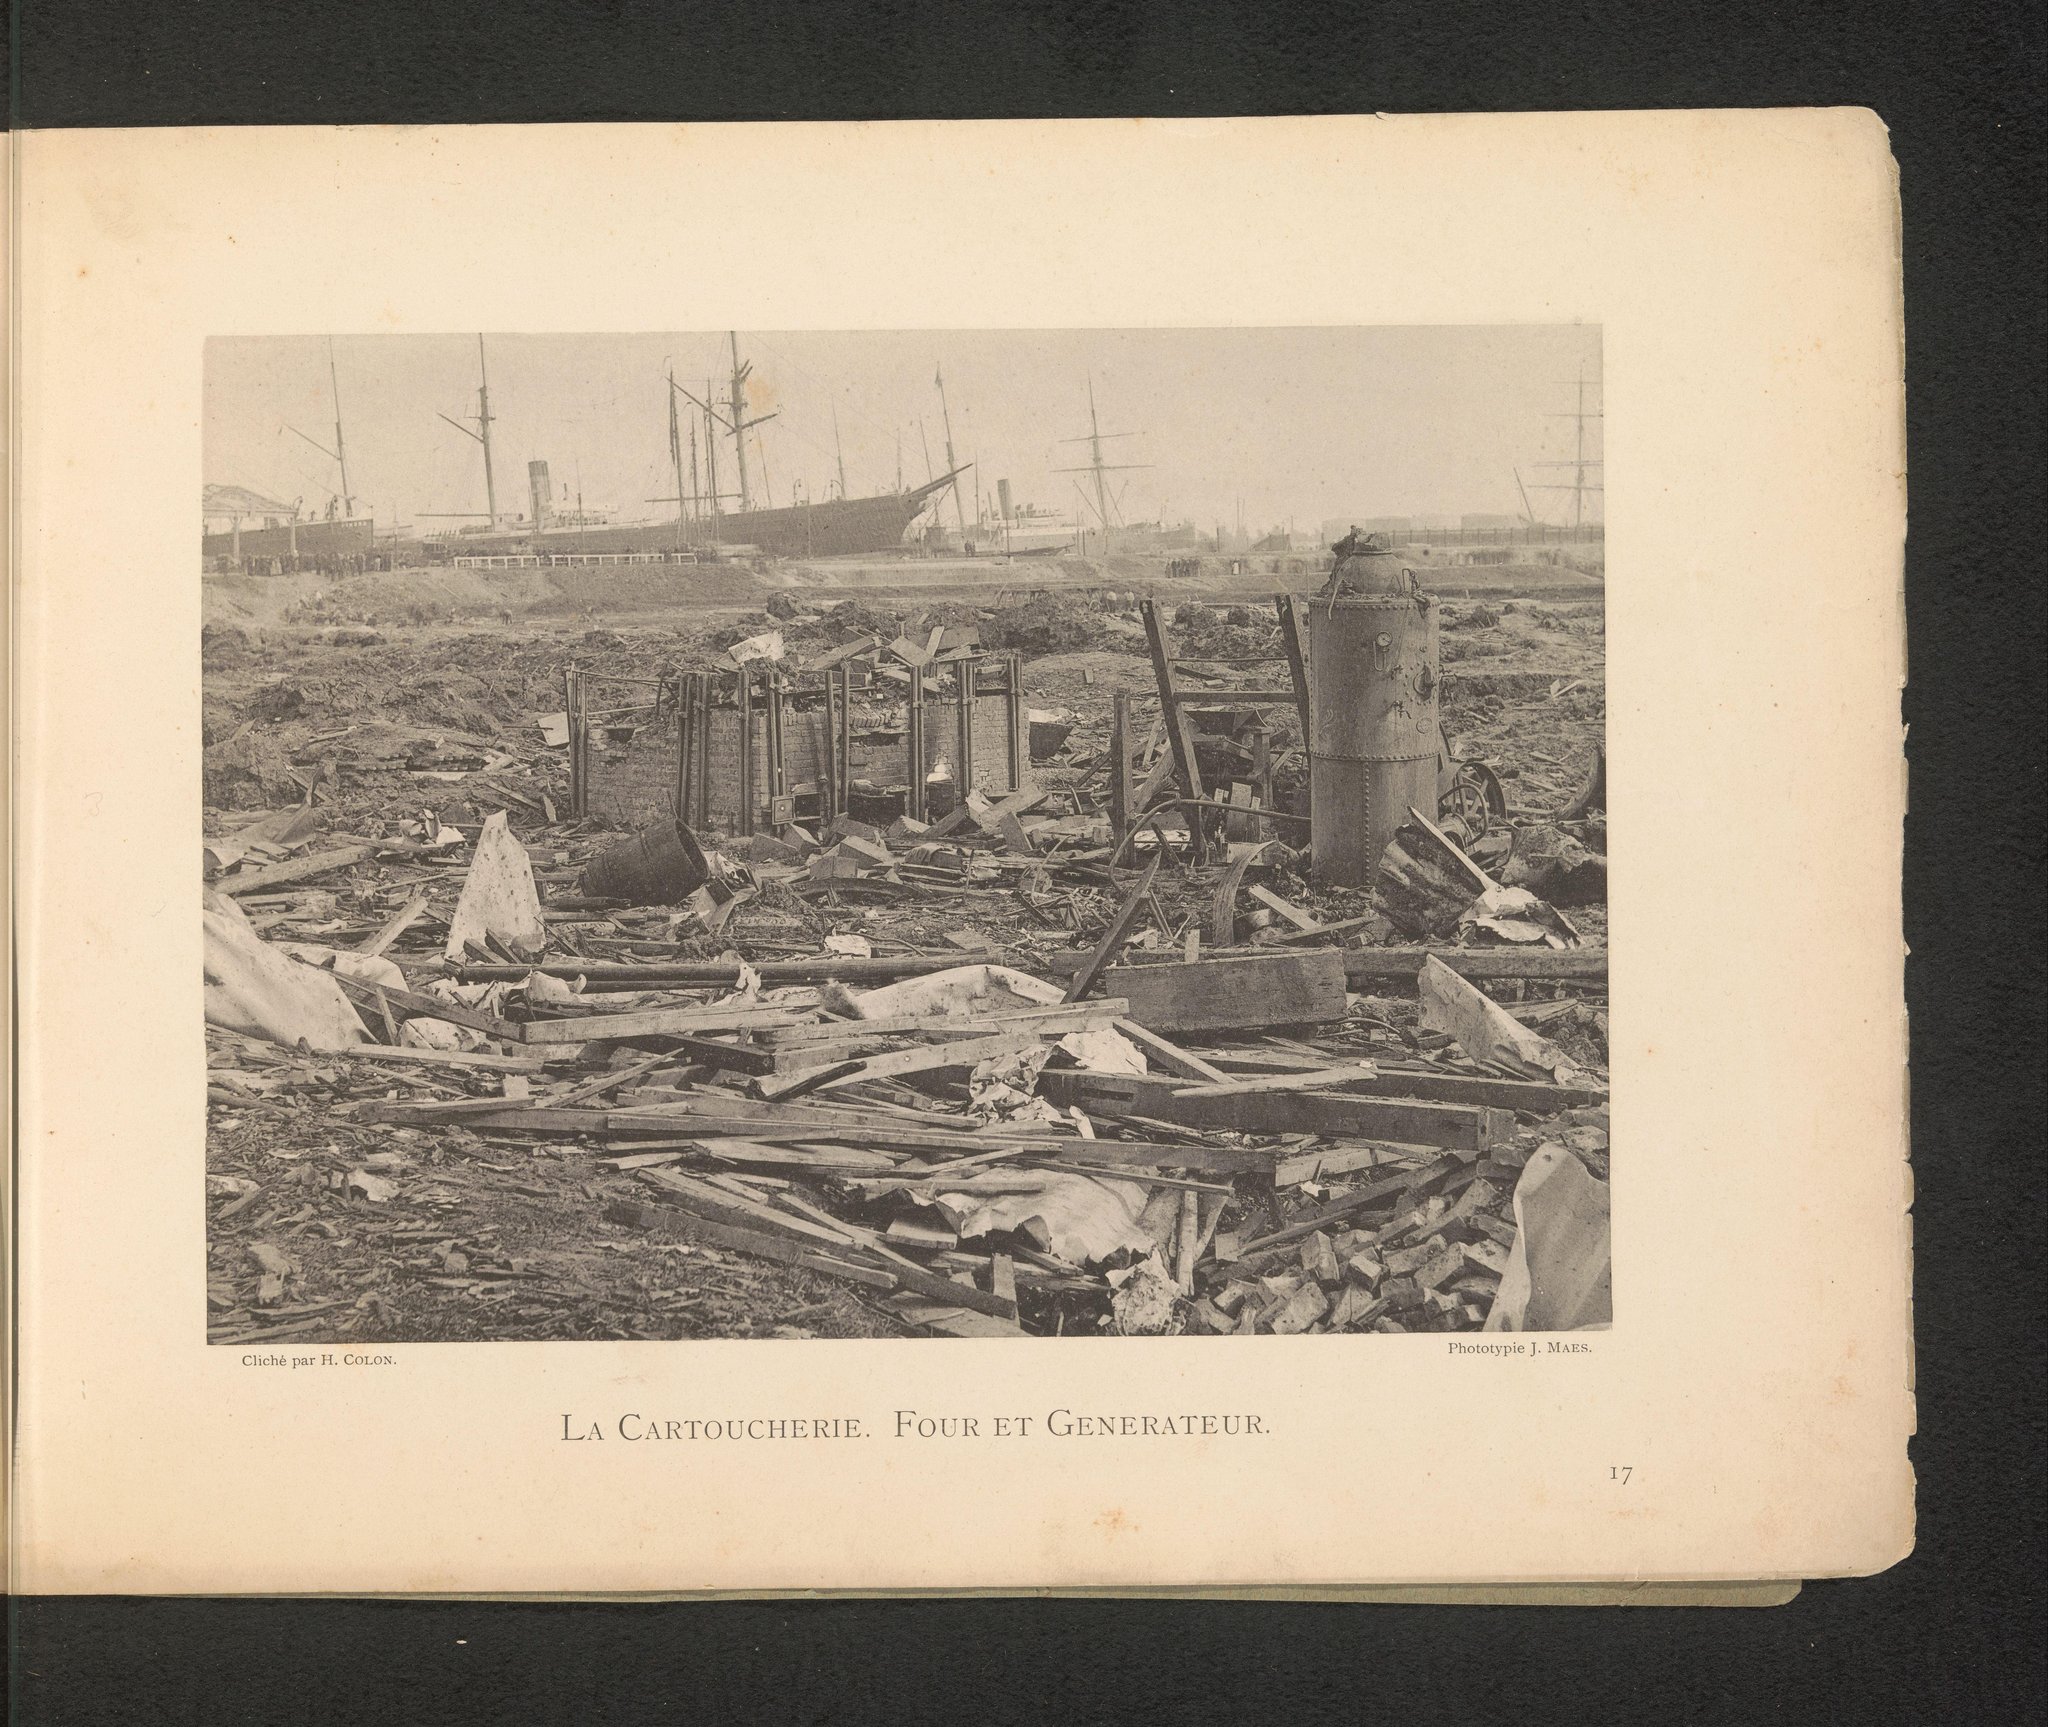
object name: page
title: Resten van een oven en generator na de ontploffing van een munitiefabriek in Oosterweel bij Antwerpen op 6 september 1889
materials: paper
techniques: photograph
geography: oosterweel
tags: machines; parts of machines; tools and appliances, ruin of a building ~ architecture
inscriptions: number: ‘17’